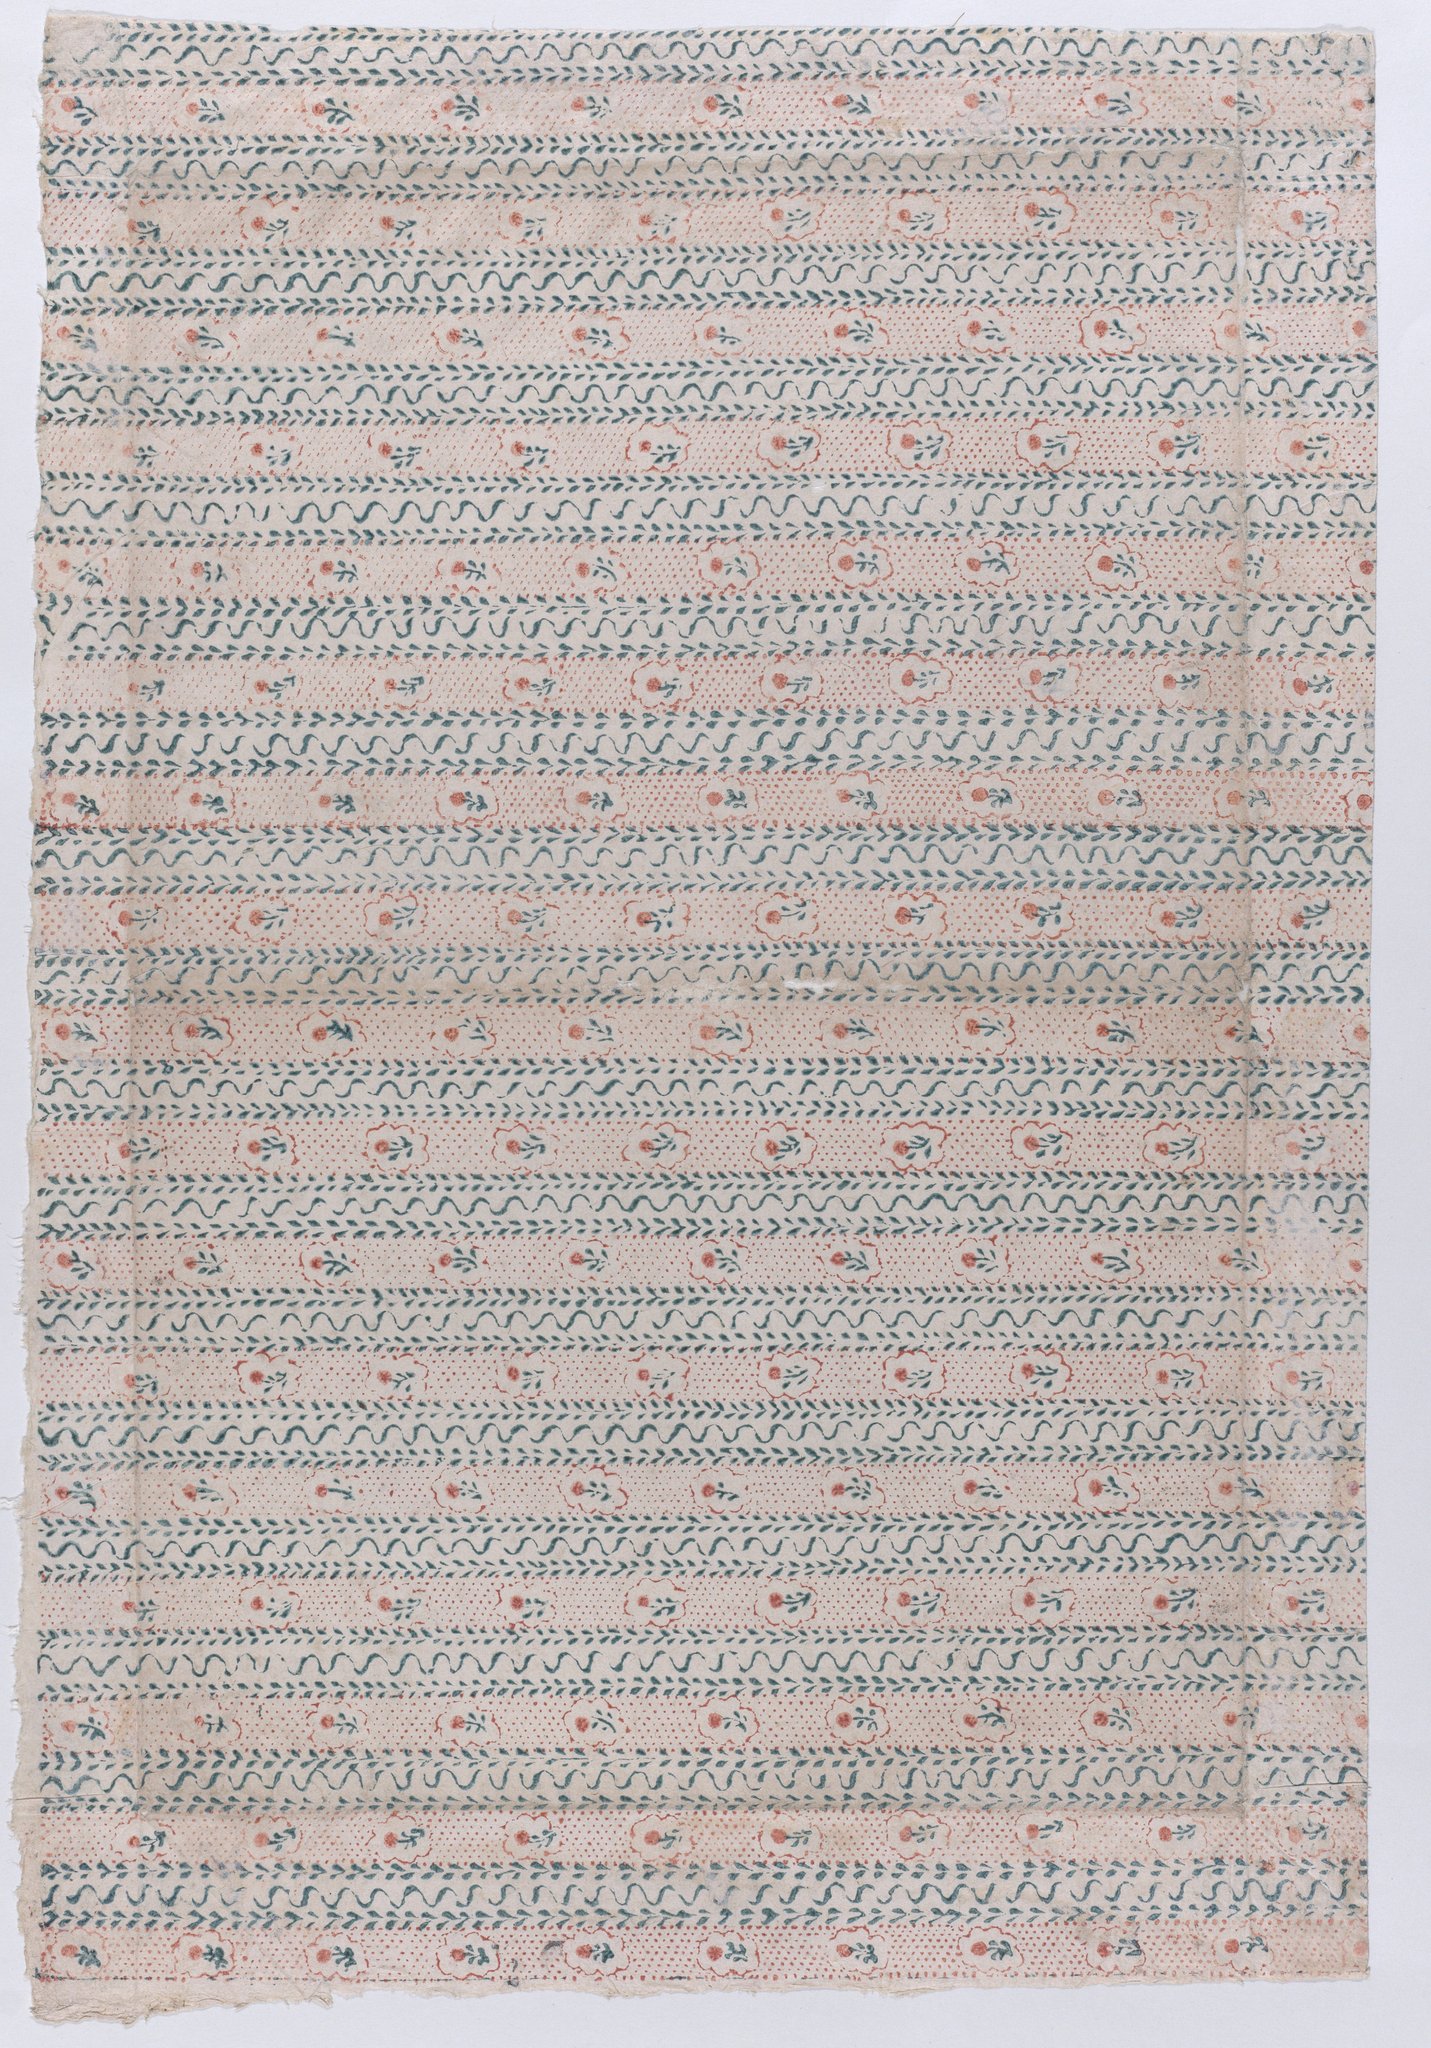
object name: print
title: Book cover with overall floral pattern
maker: Anonymous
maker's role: artist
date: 1701-1800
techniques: relief print